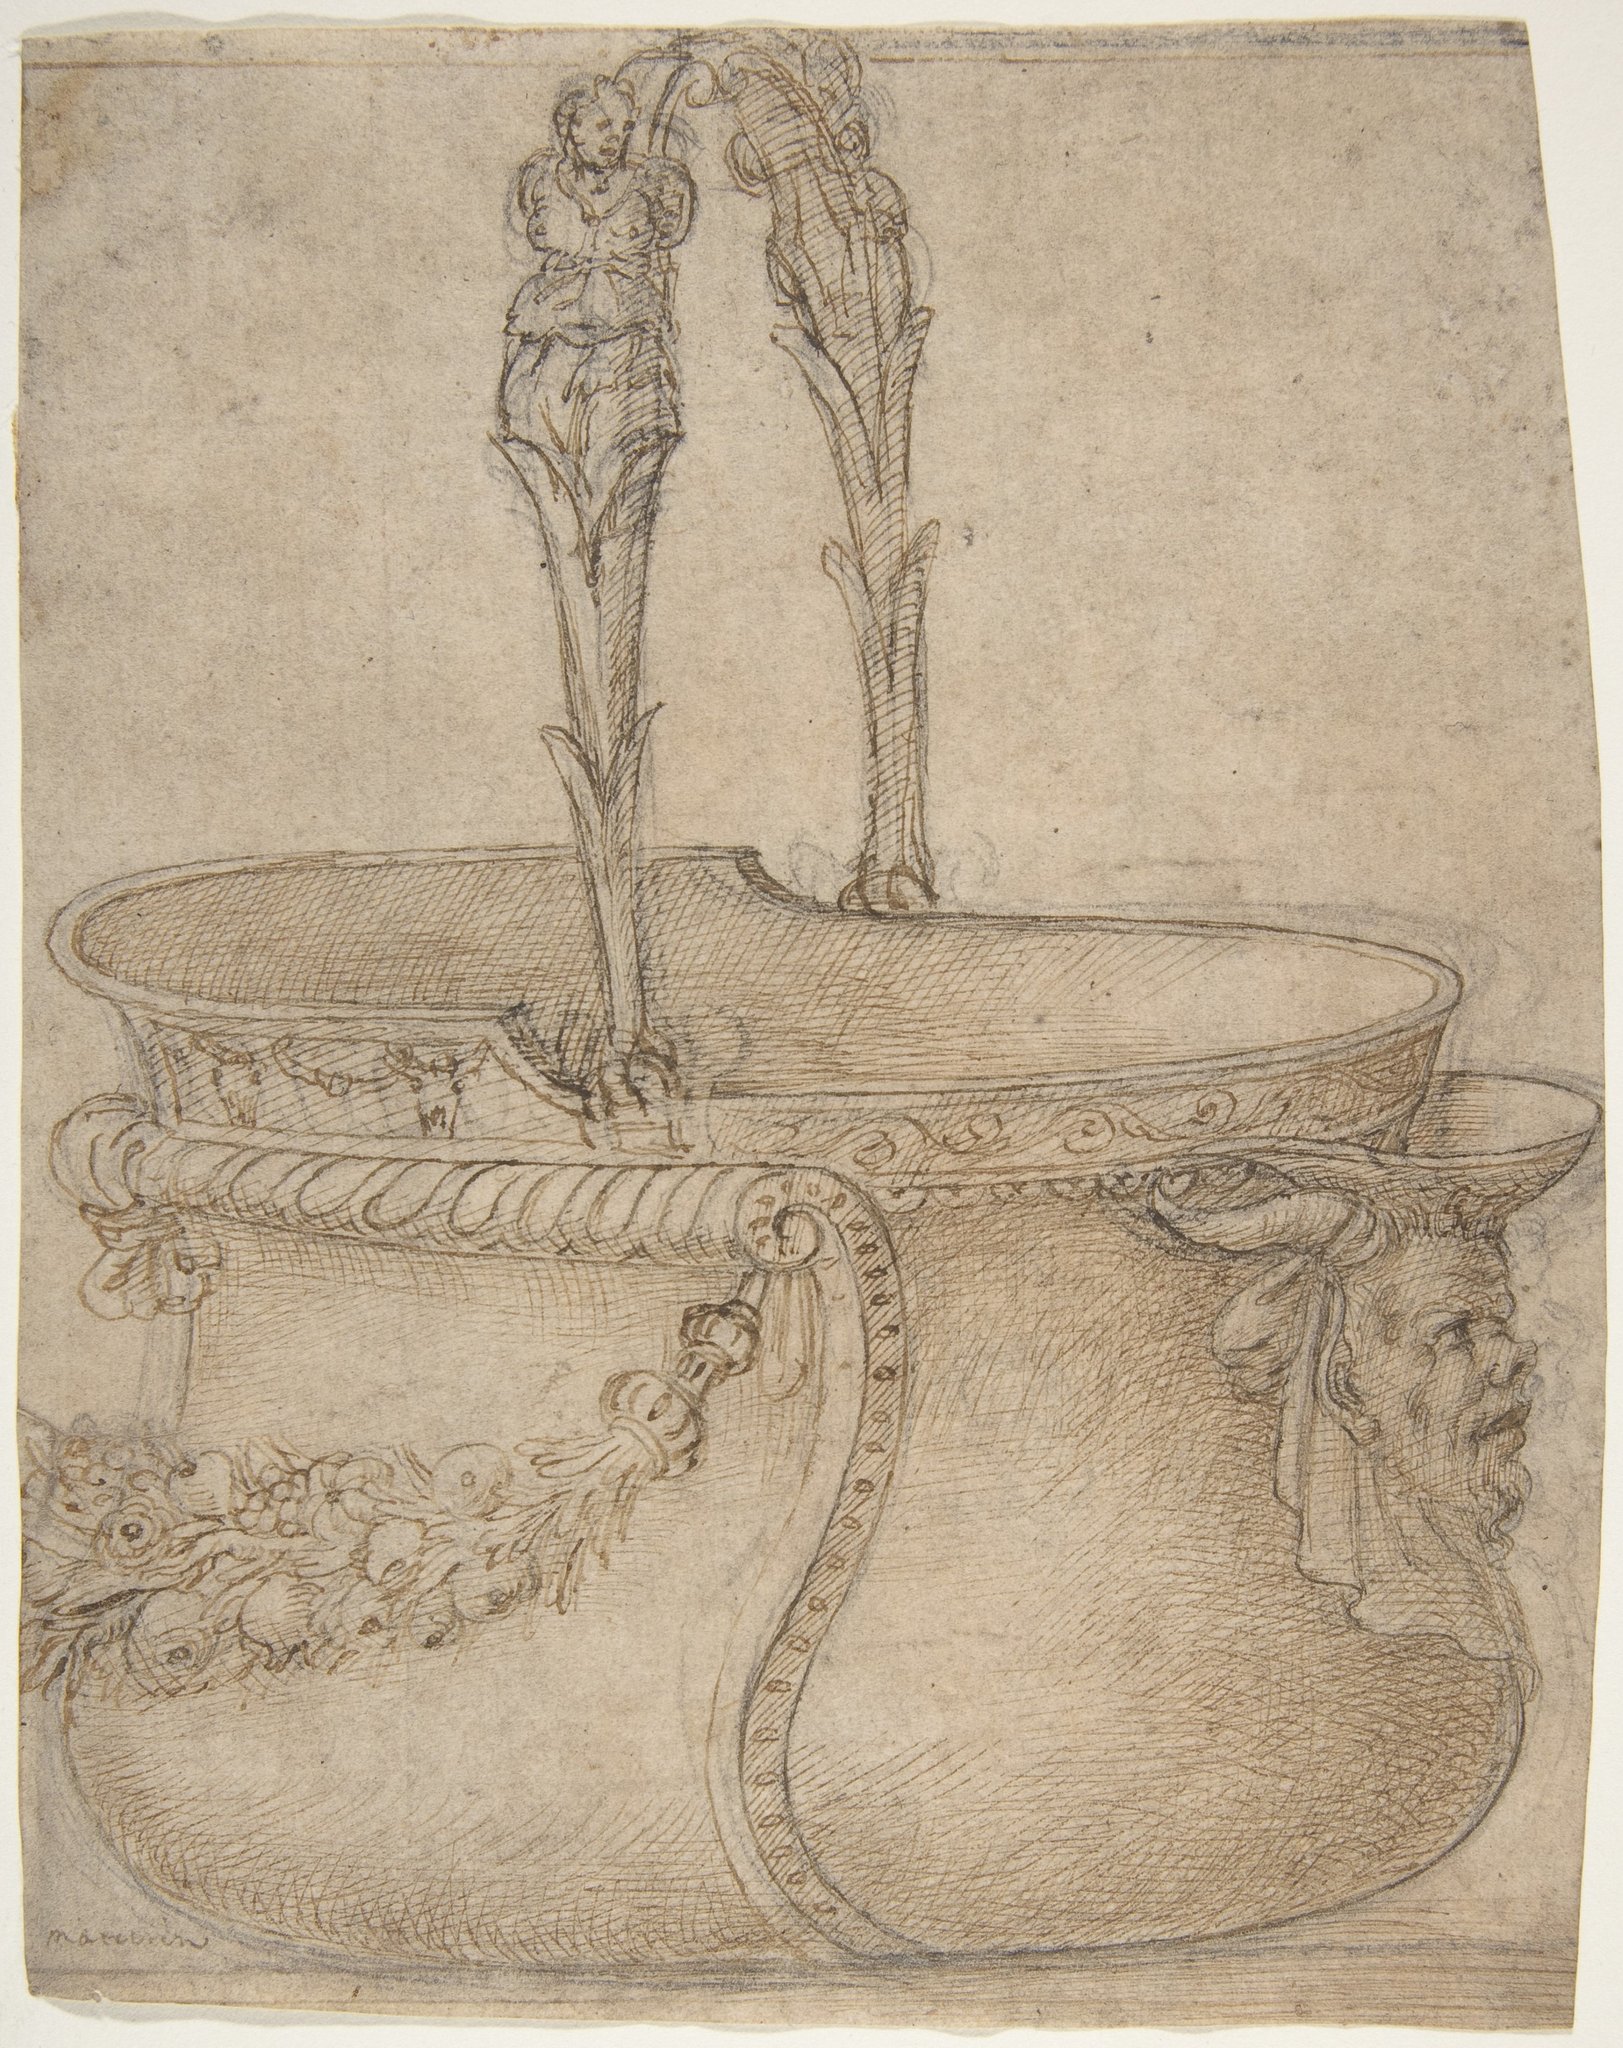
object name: drawing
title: Design for a Bucket-Like Vessel with a Handle of Two Interlaced Captives, on a Body Adorned with a Scroll, Garland, and a Spout with a Satyr's Head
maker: girolamo genga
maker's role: artist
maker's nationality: italian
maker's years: 1467-1551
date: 1540-1550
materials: chalk, ink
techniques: pen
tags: satyrs,vessels